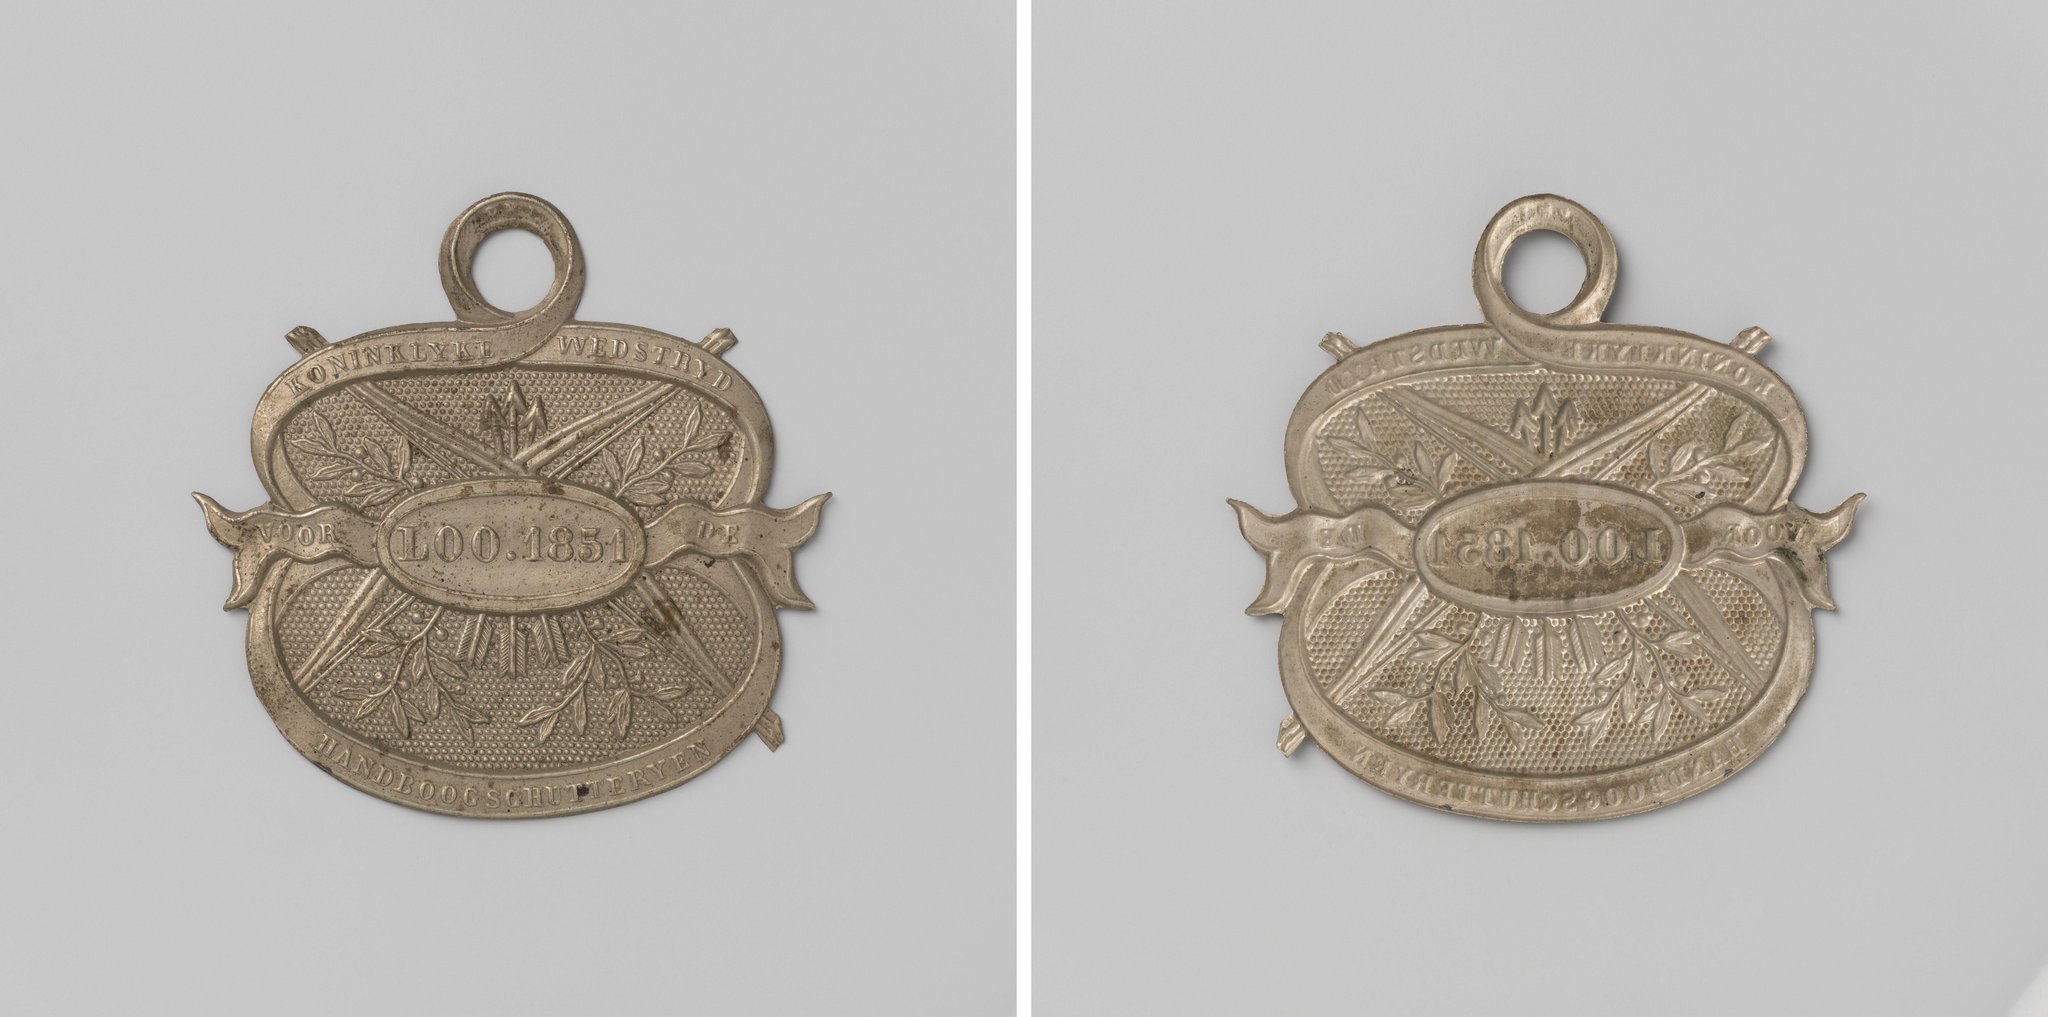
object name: marksman medal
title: Koninklijke wedstrijd voor handboogschutterijen op het Loo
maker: Anonymous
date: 1851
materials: silver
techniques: striking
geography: netherlands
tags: paleis het loo